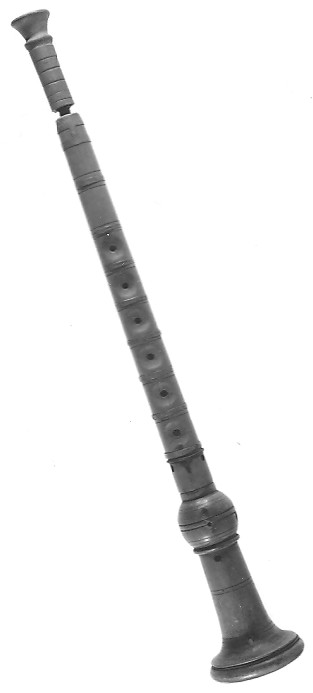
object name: sopila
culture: eastern european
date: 1867-1900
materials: metal, wood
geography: croatia